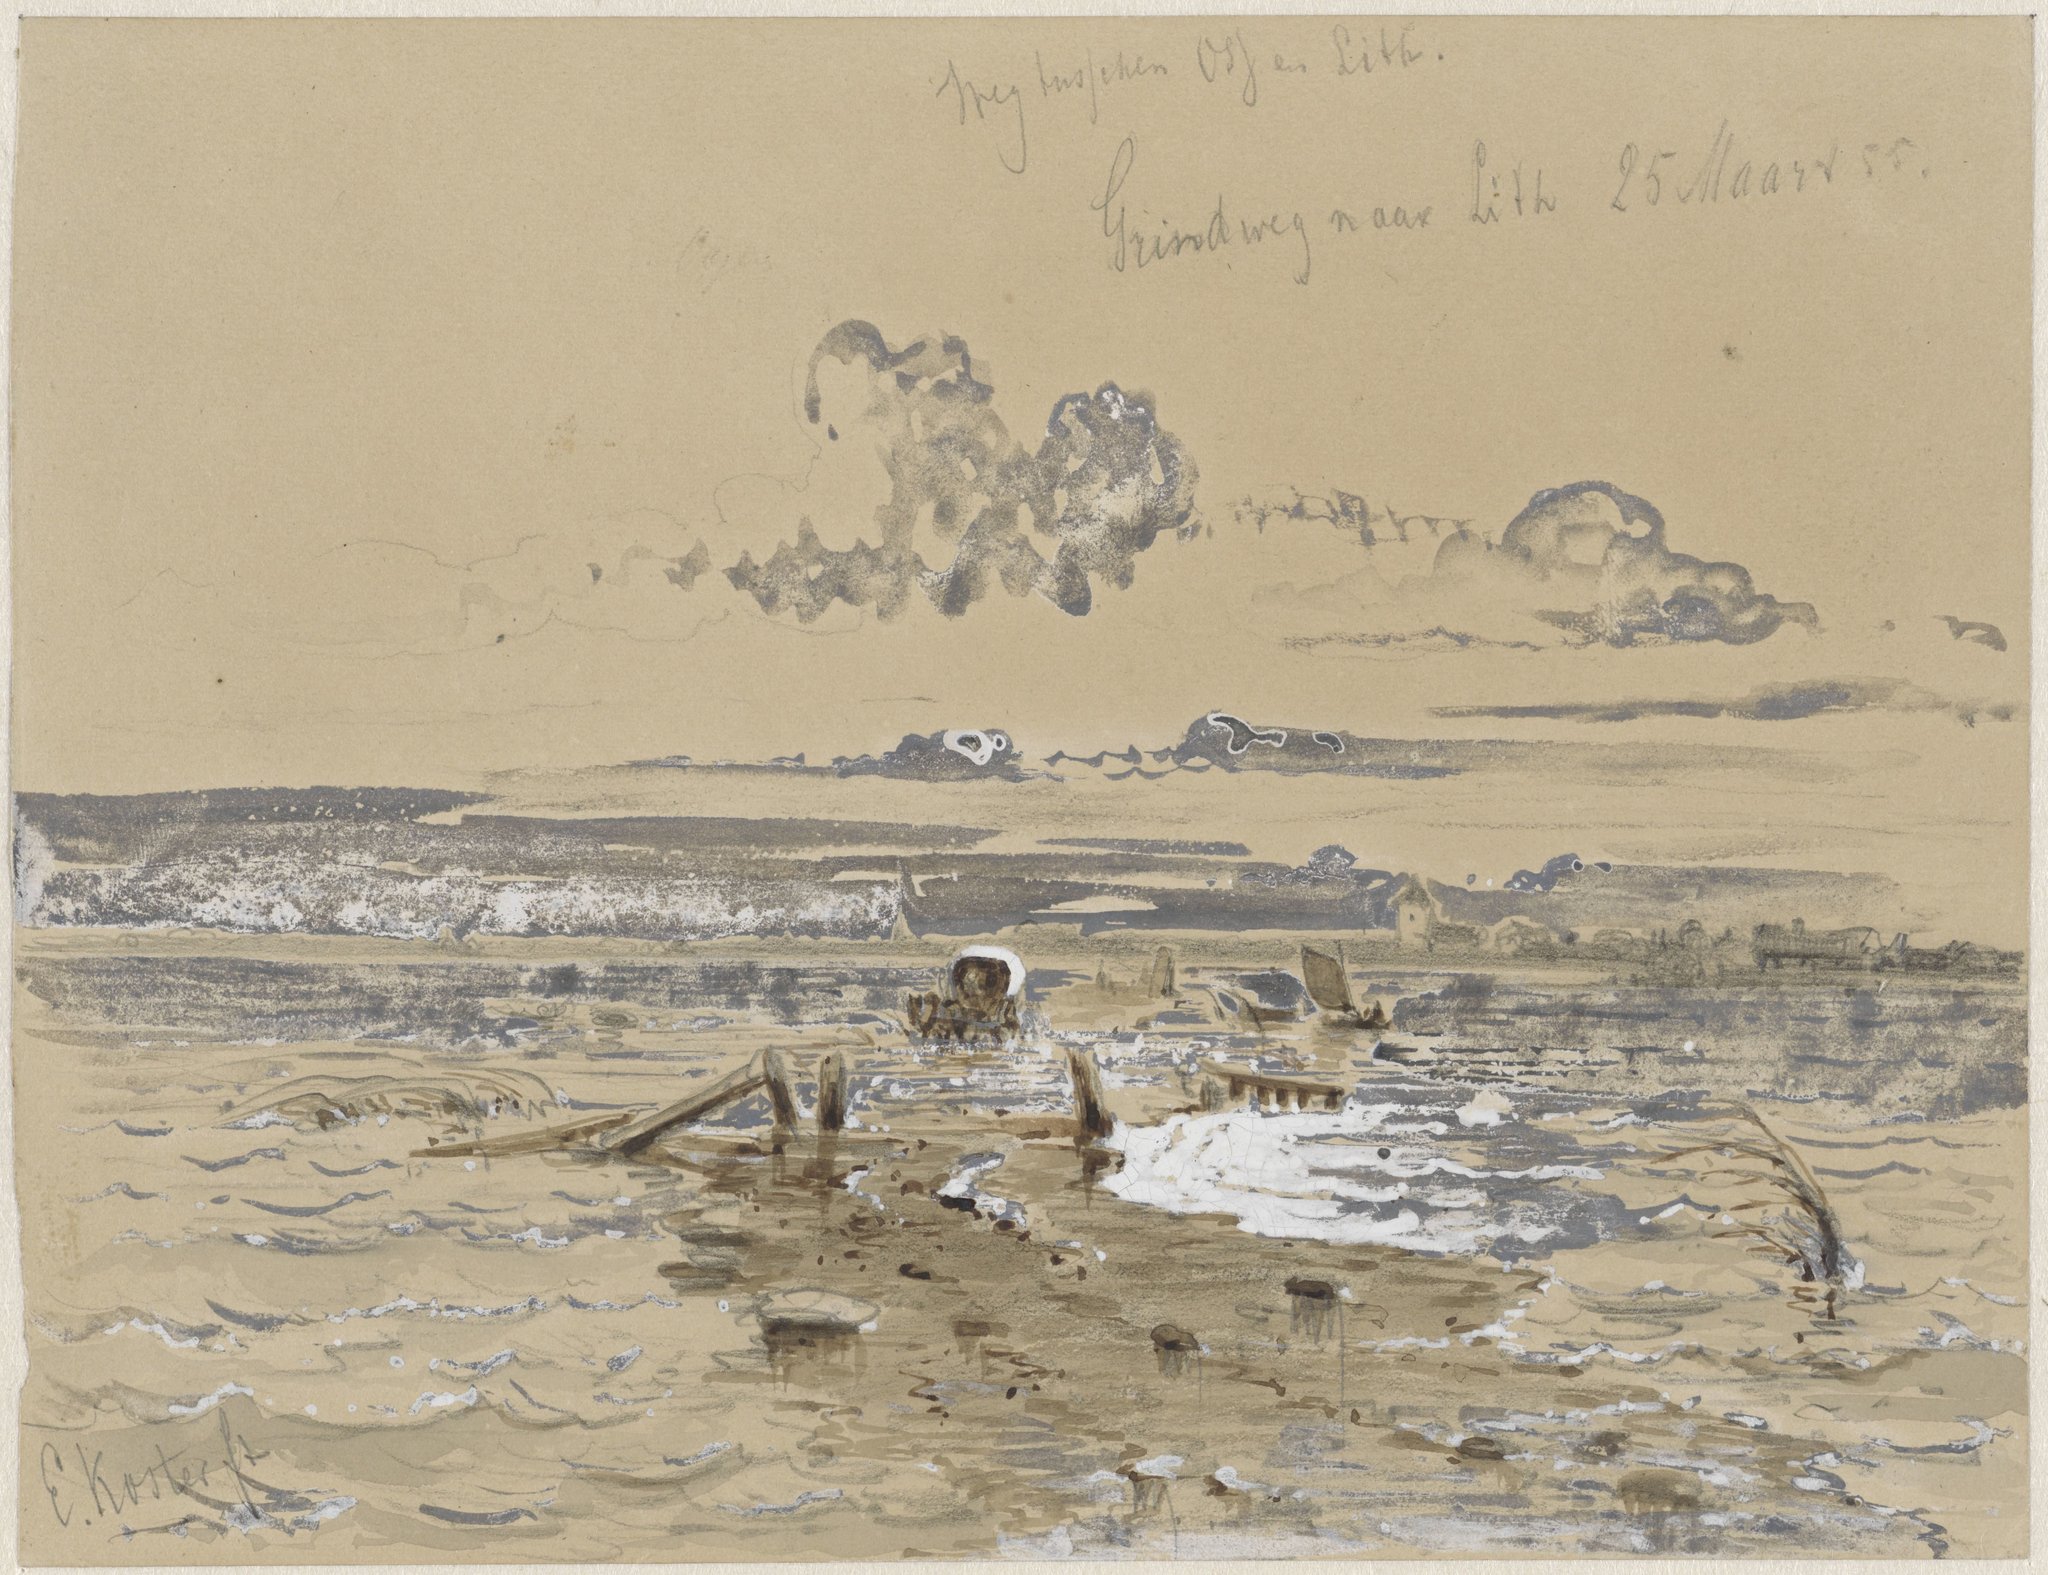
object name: drawing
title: Landschap met de grindweg tussen Oss en Lithoijen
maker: everhardus koster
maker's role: draughtsman, painter, print maker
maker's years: 1817-1892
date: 1855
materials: paint, paper, pencil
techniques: brush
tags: landscapes in the temperate zone, oss